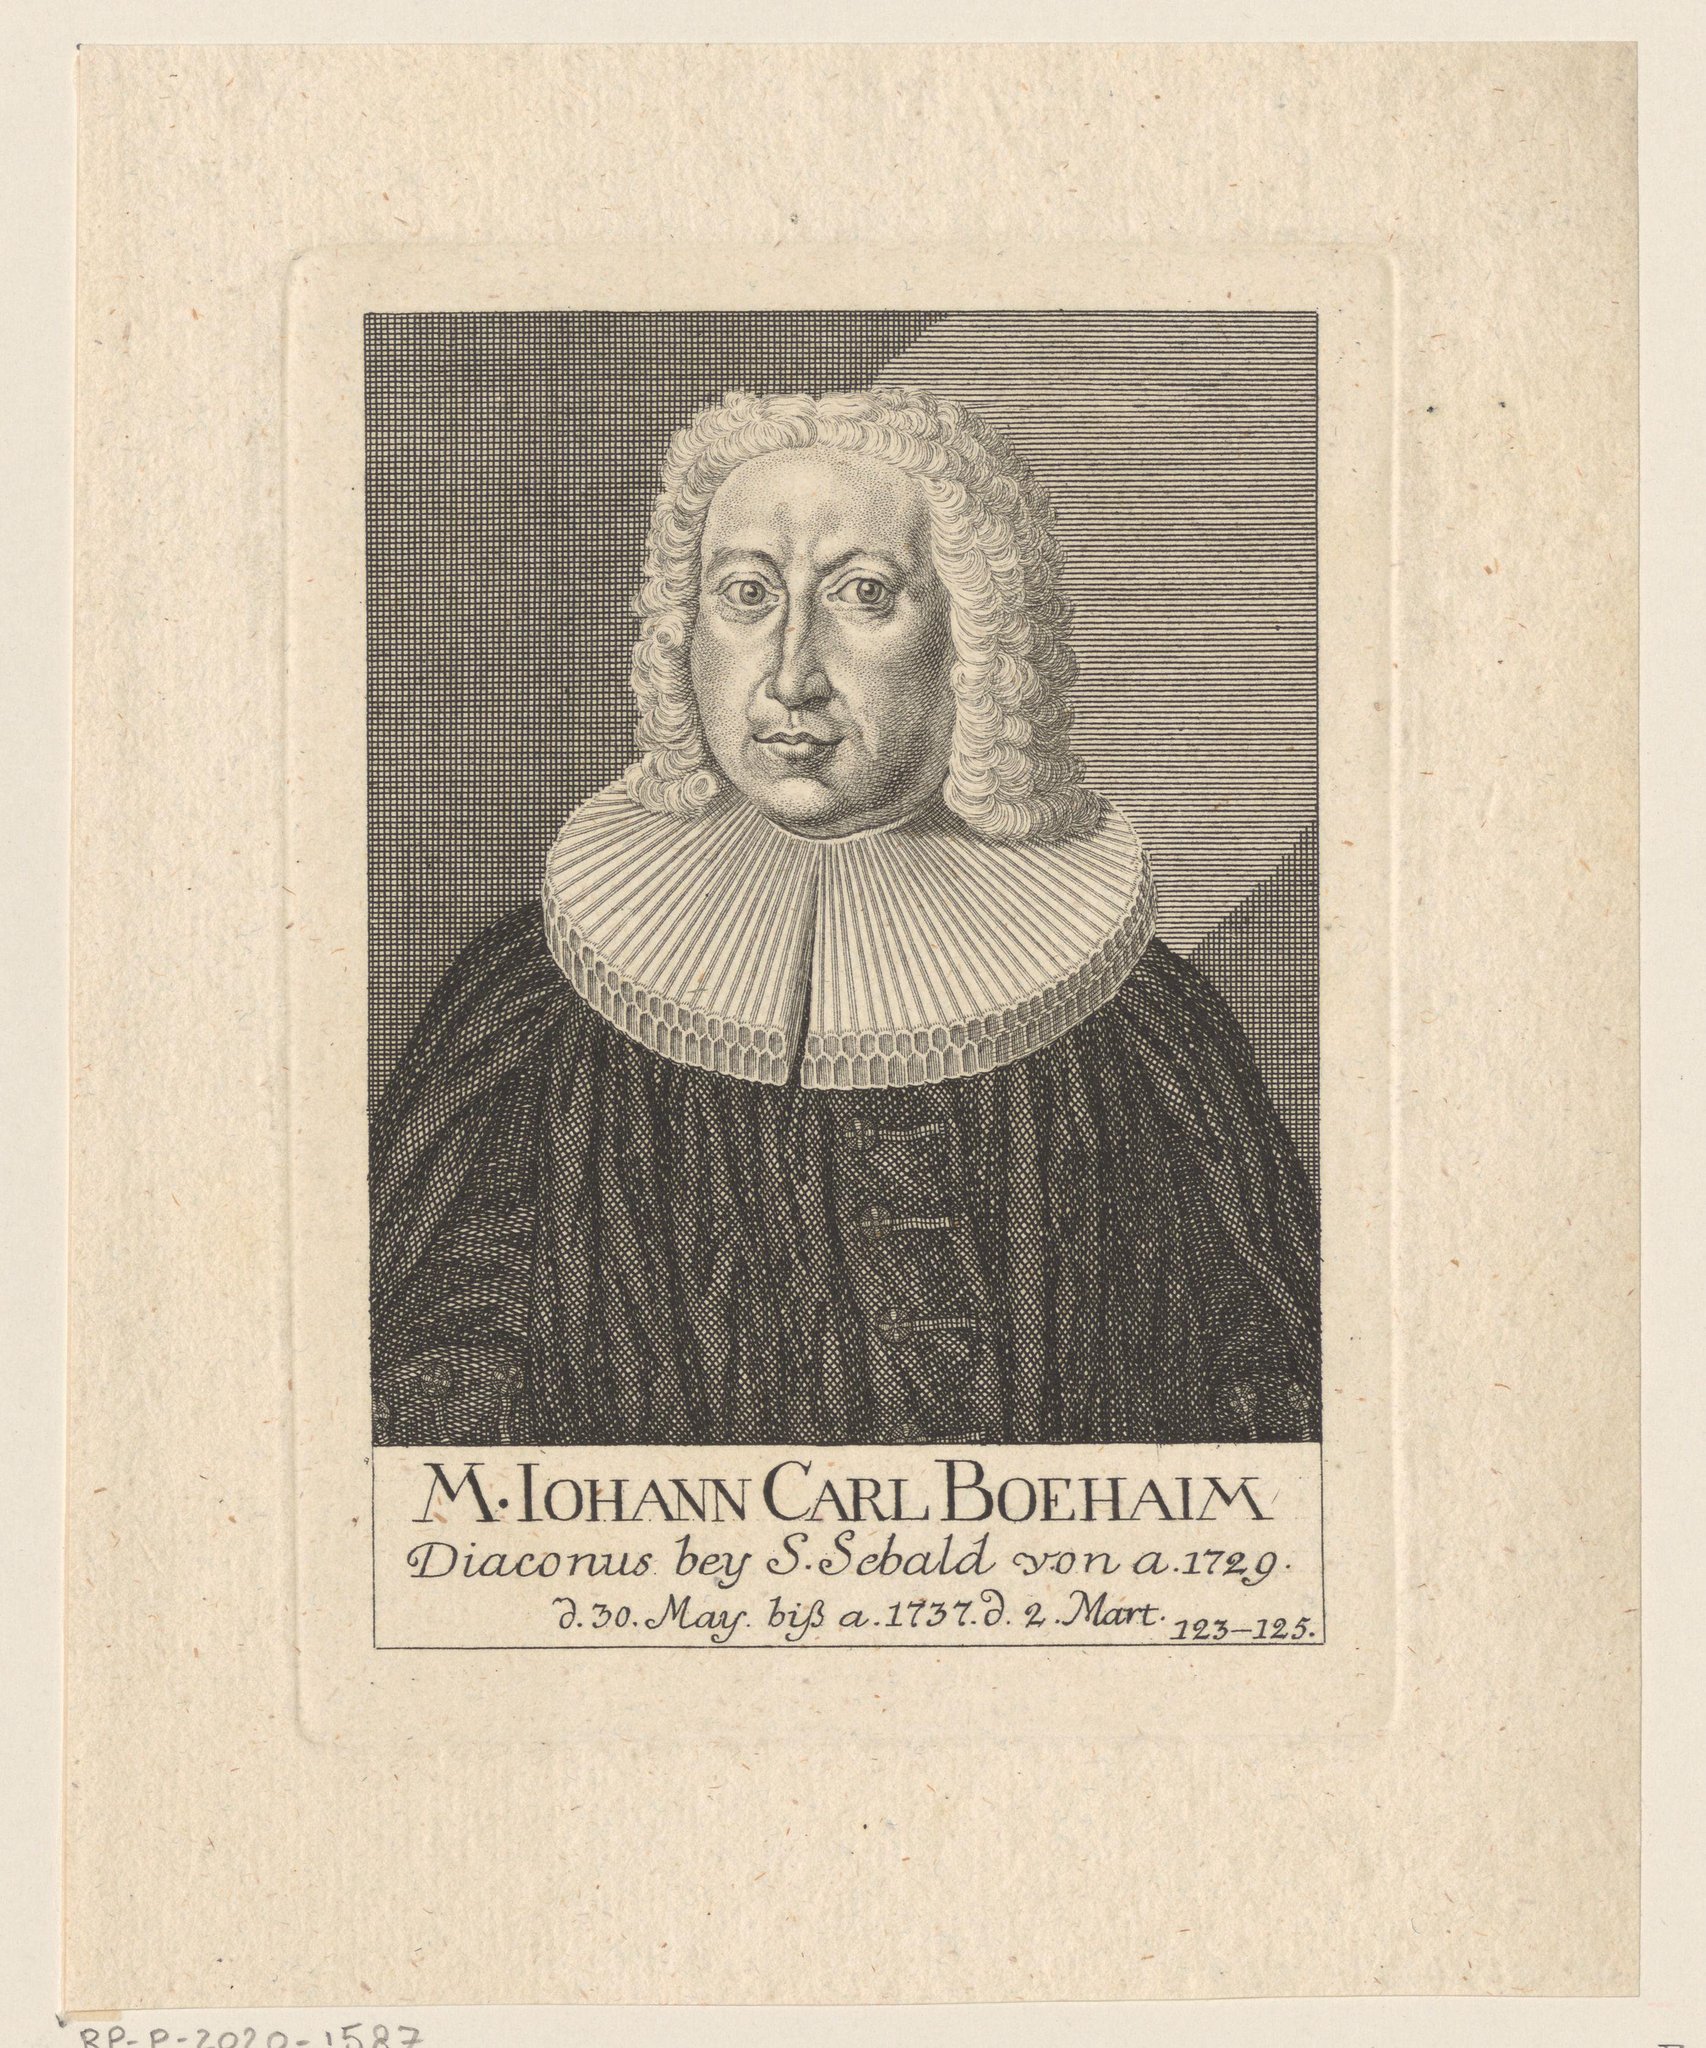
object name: book illustration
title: Portret van Johann Carl Böhaim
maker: christoph melchior roth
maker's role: print maker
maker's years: 1720-1798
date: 1756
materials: paper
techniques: engraving, etching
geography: nuremberg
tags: theologian, historical persons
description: Prent uit: Würfel, Andreas. Diptycha ecclesiae Sebaldianae (...). Neurenberg: Christoph Melchior Roth, 1756.